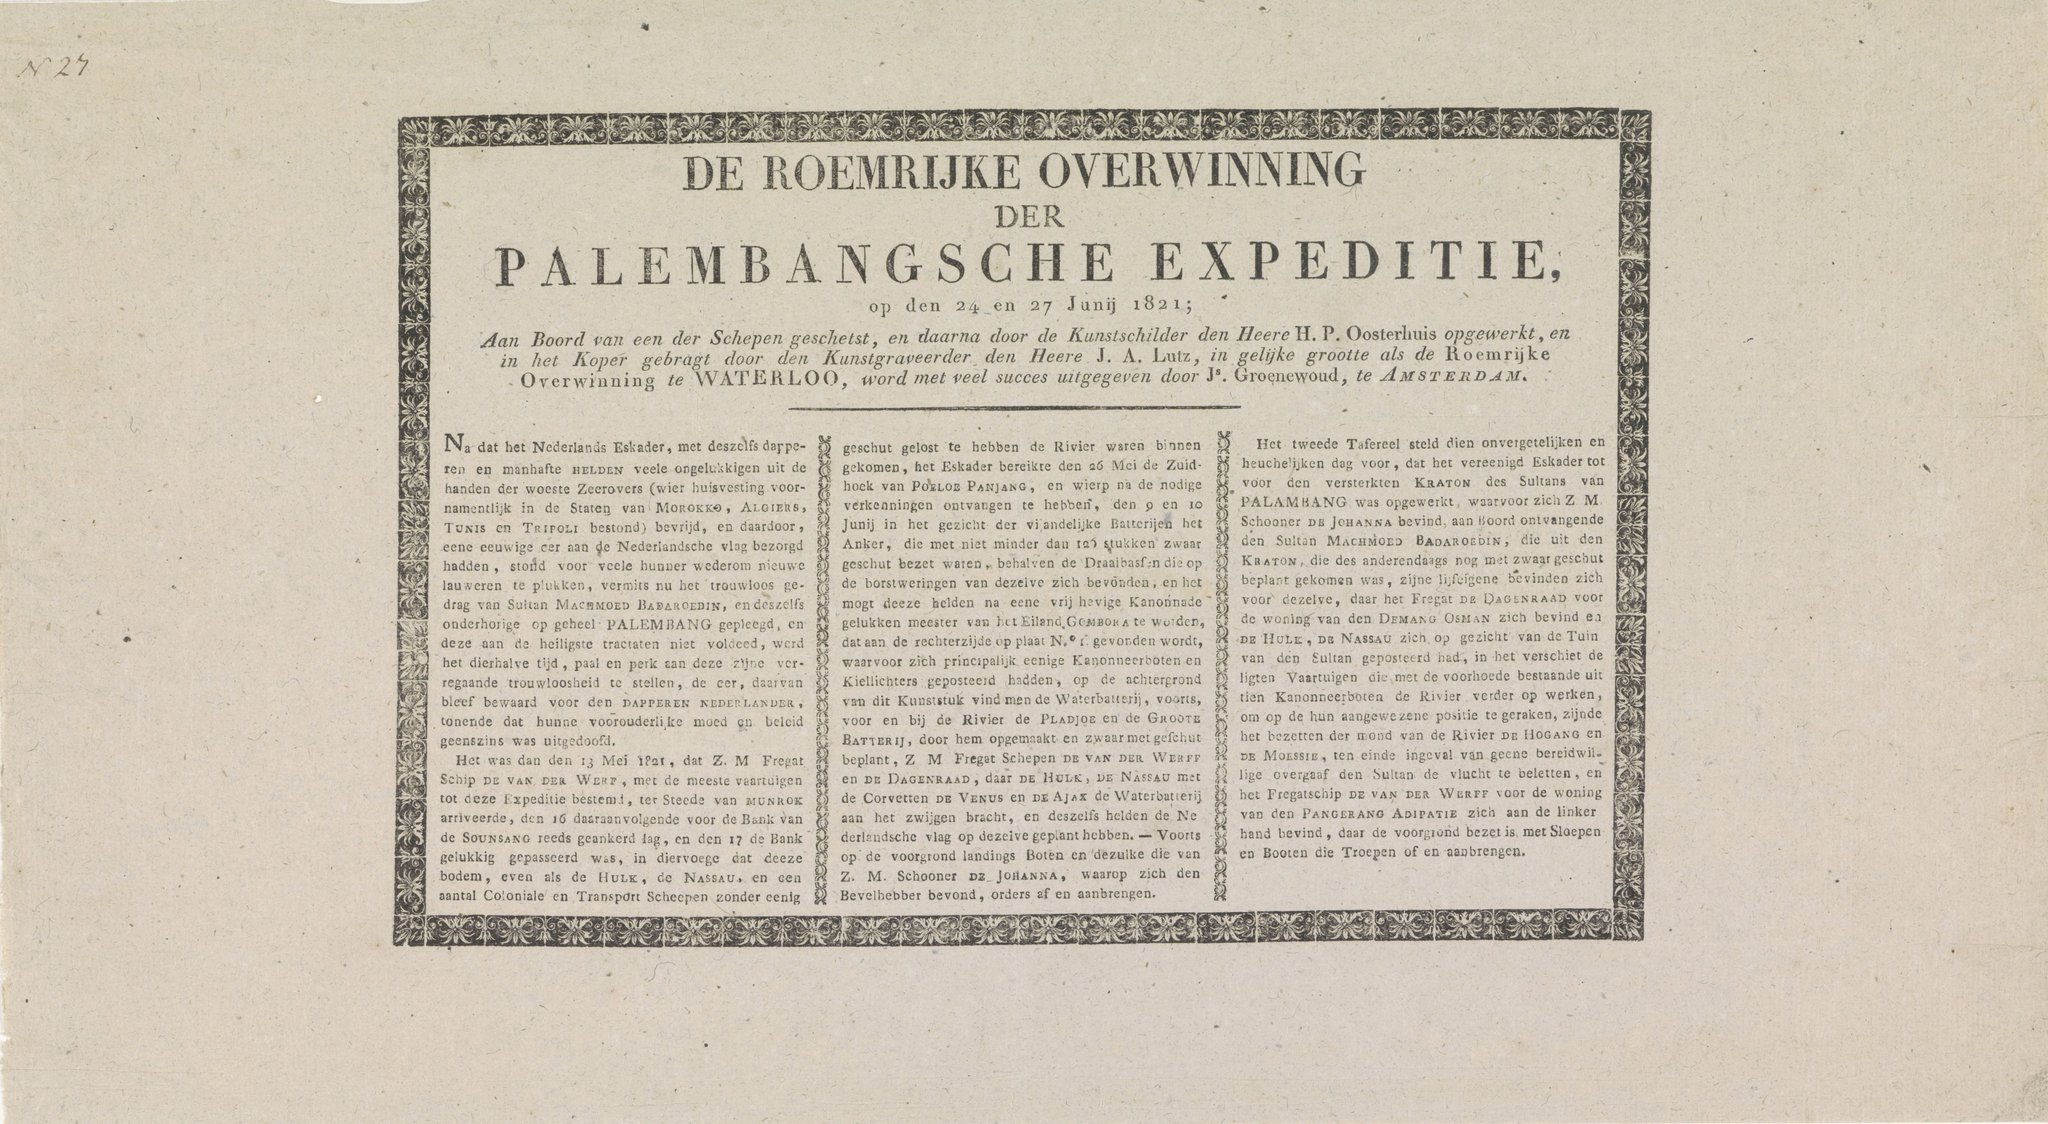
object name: text sheet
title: Verklaring bij de prent van de overwinning op Palembang, 1821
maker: j. groenewoud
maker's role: publisher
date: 1821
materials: paper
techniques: letterpress printing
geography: amsterdam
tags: palembang, tweede expeditie naar palembang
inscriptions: collector's mark: Lugt 2228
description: Tekstblad met gedrukte verklaring van de voorstelling van de prent van de overwinning tijdens de tweede expeditie naar Palembang, 24 juni 1821. Tekst in drie kolommen, binnen decoratieve kader van fileetwerk.